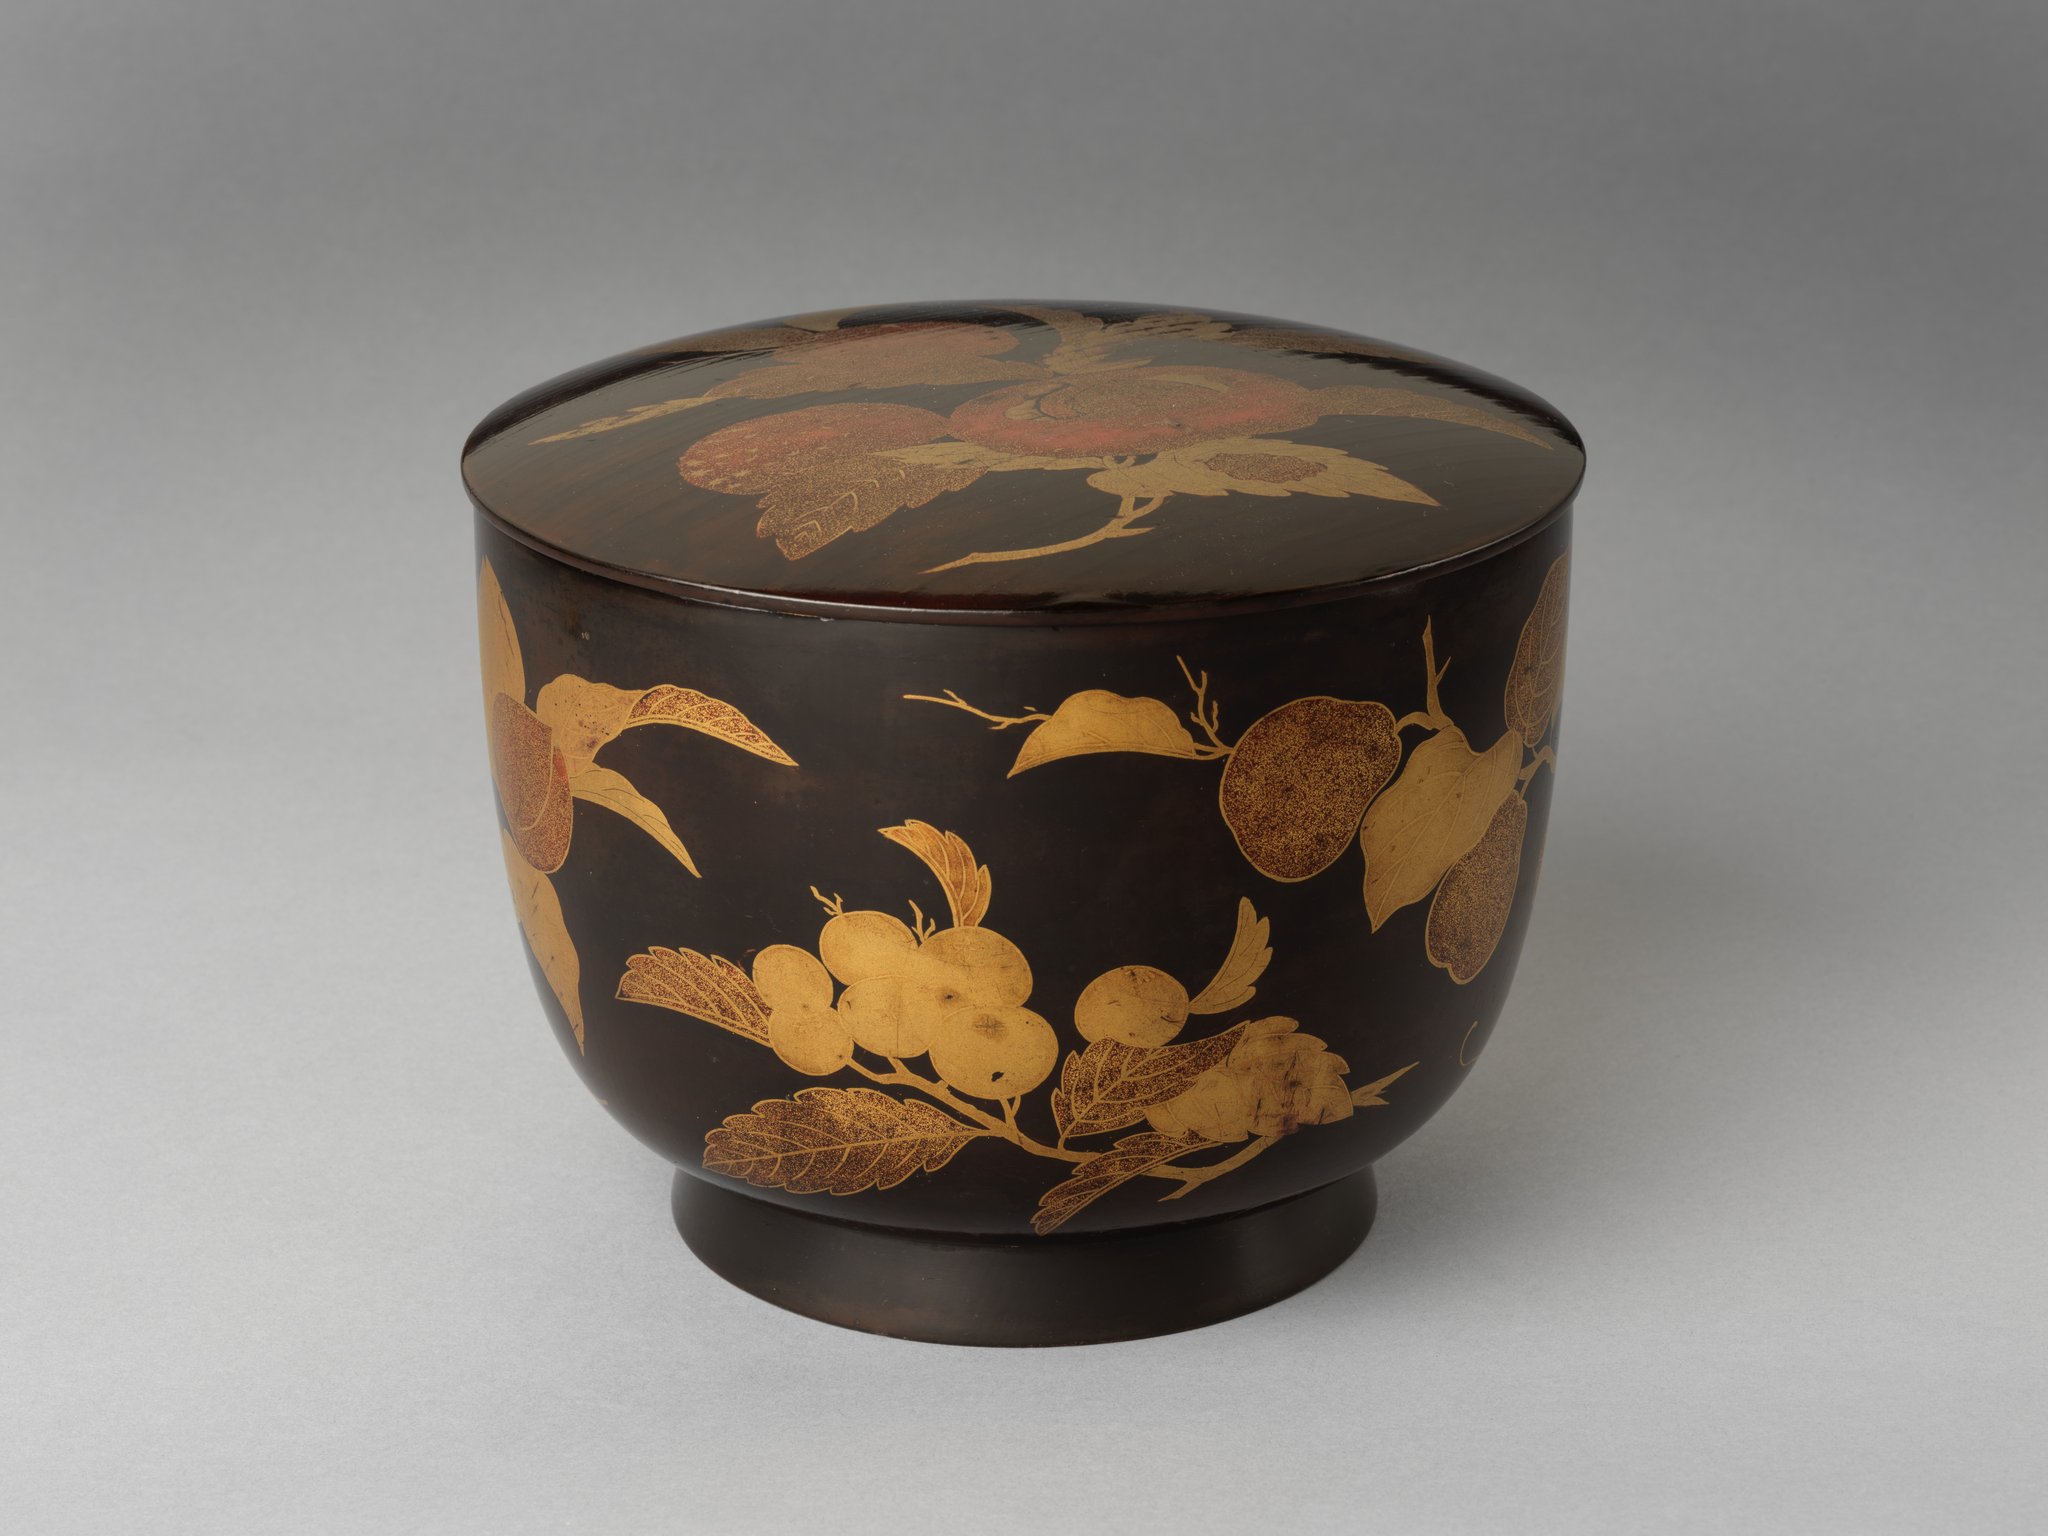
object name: bowl with cover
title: Rice server with decoration of autumn fruit on a branch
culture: japanese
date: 1601-1650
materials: gold, lacquer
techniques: maki